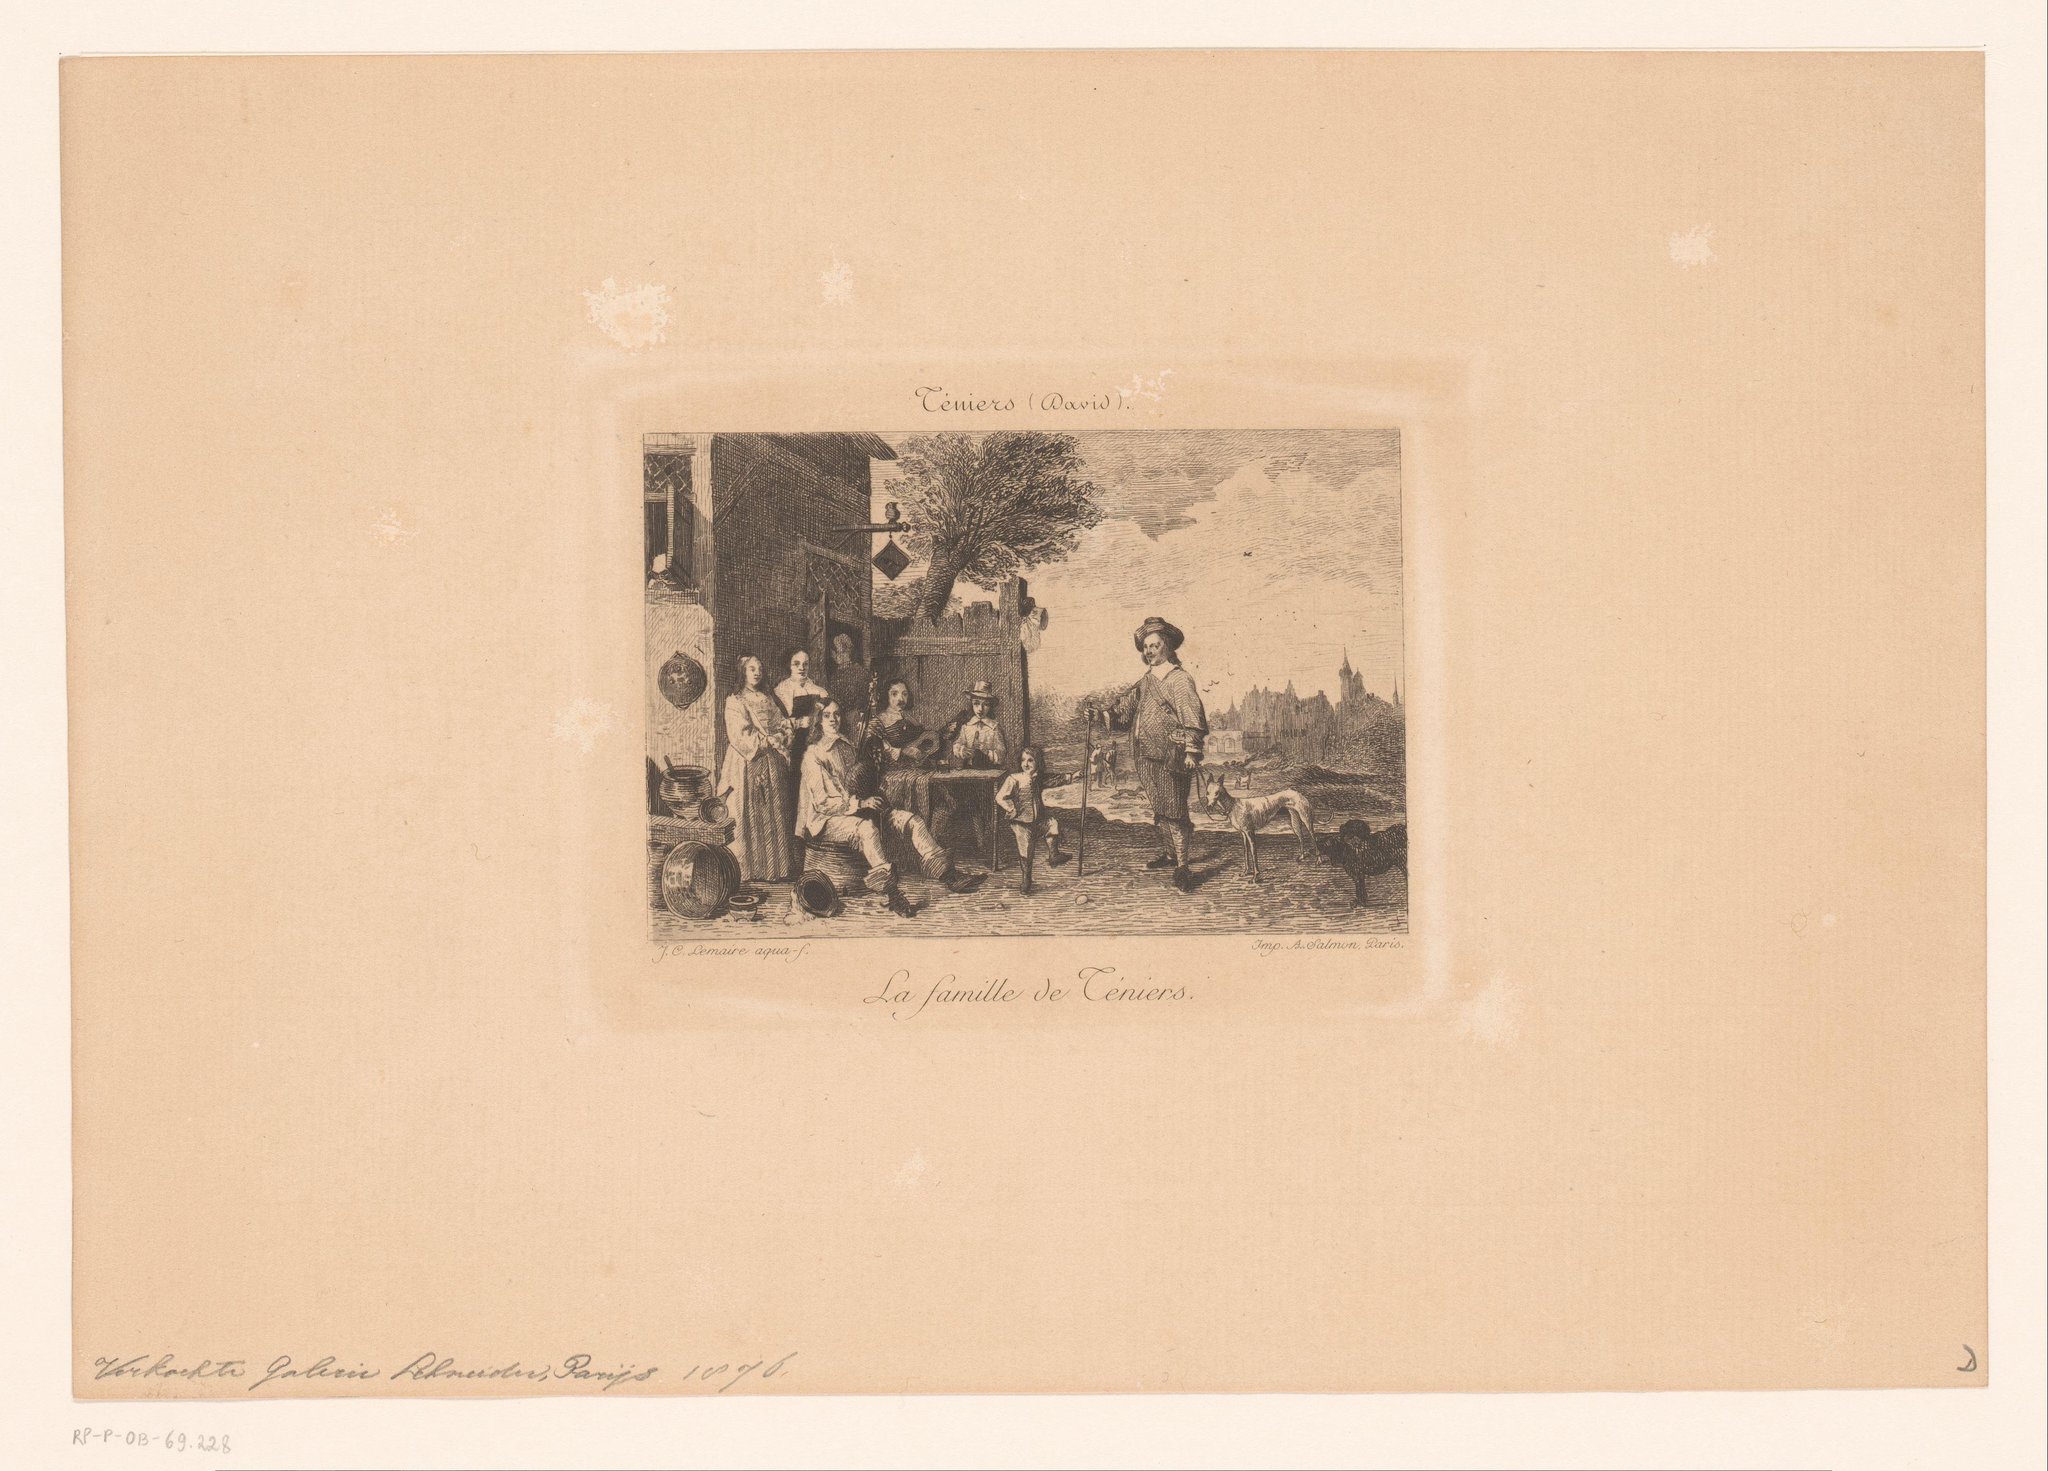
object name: print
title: Familieportret van David Teniers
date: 1835-1925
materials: paper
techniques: drypoint, engraving, etching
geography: paris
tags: david teniers, rural housing, e.g. country-house, villa, cottage, family, relationship, descent, dog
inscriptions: collector's mark: Lugt 2228